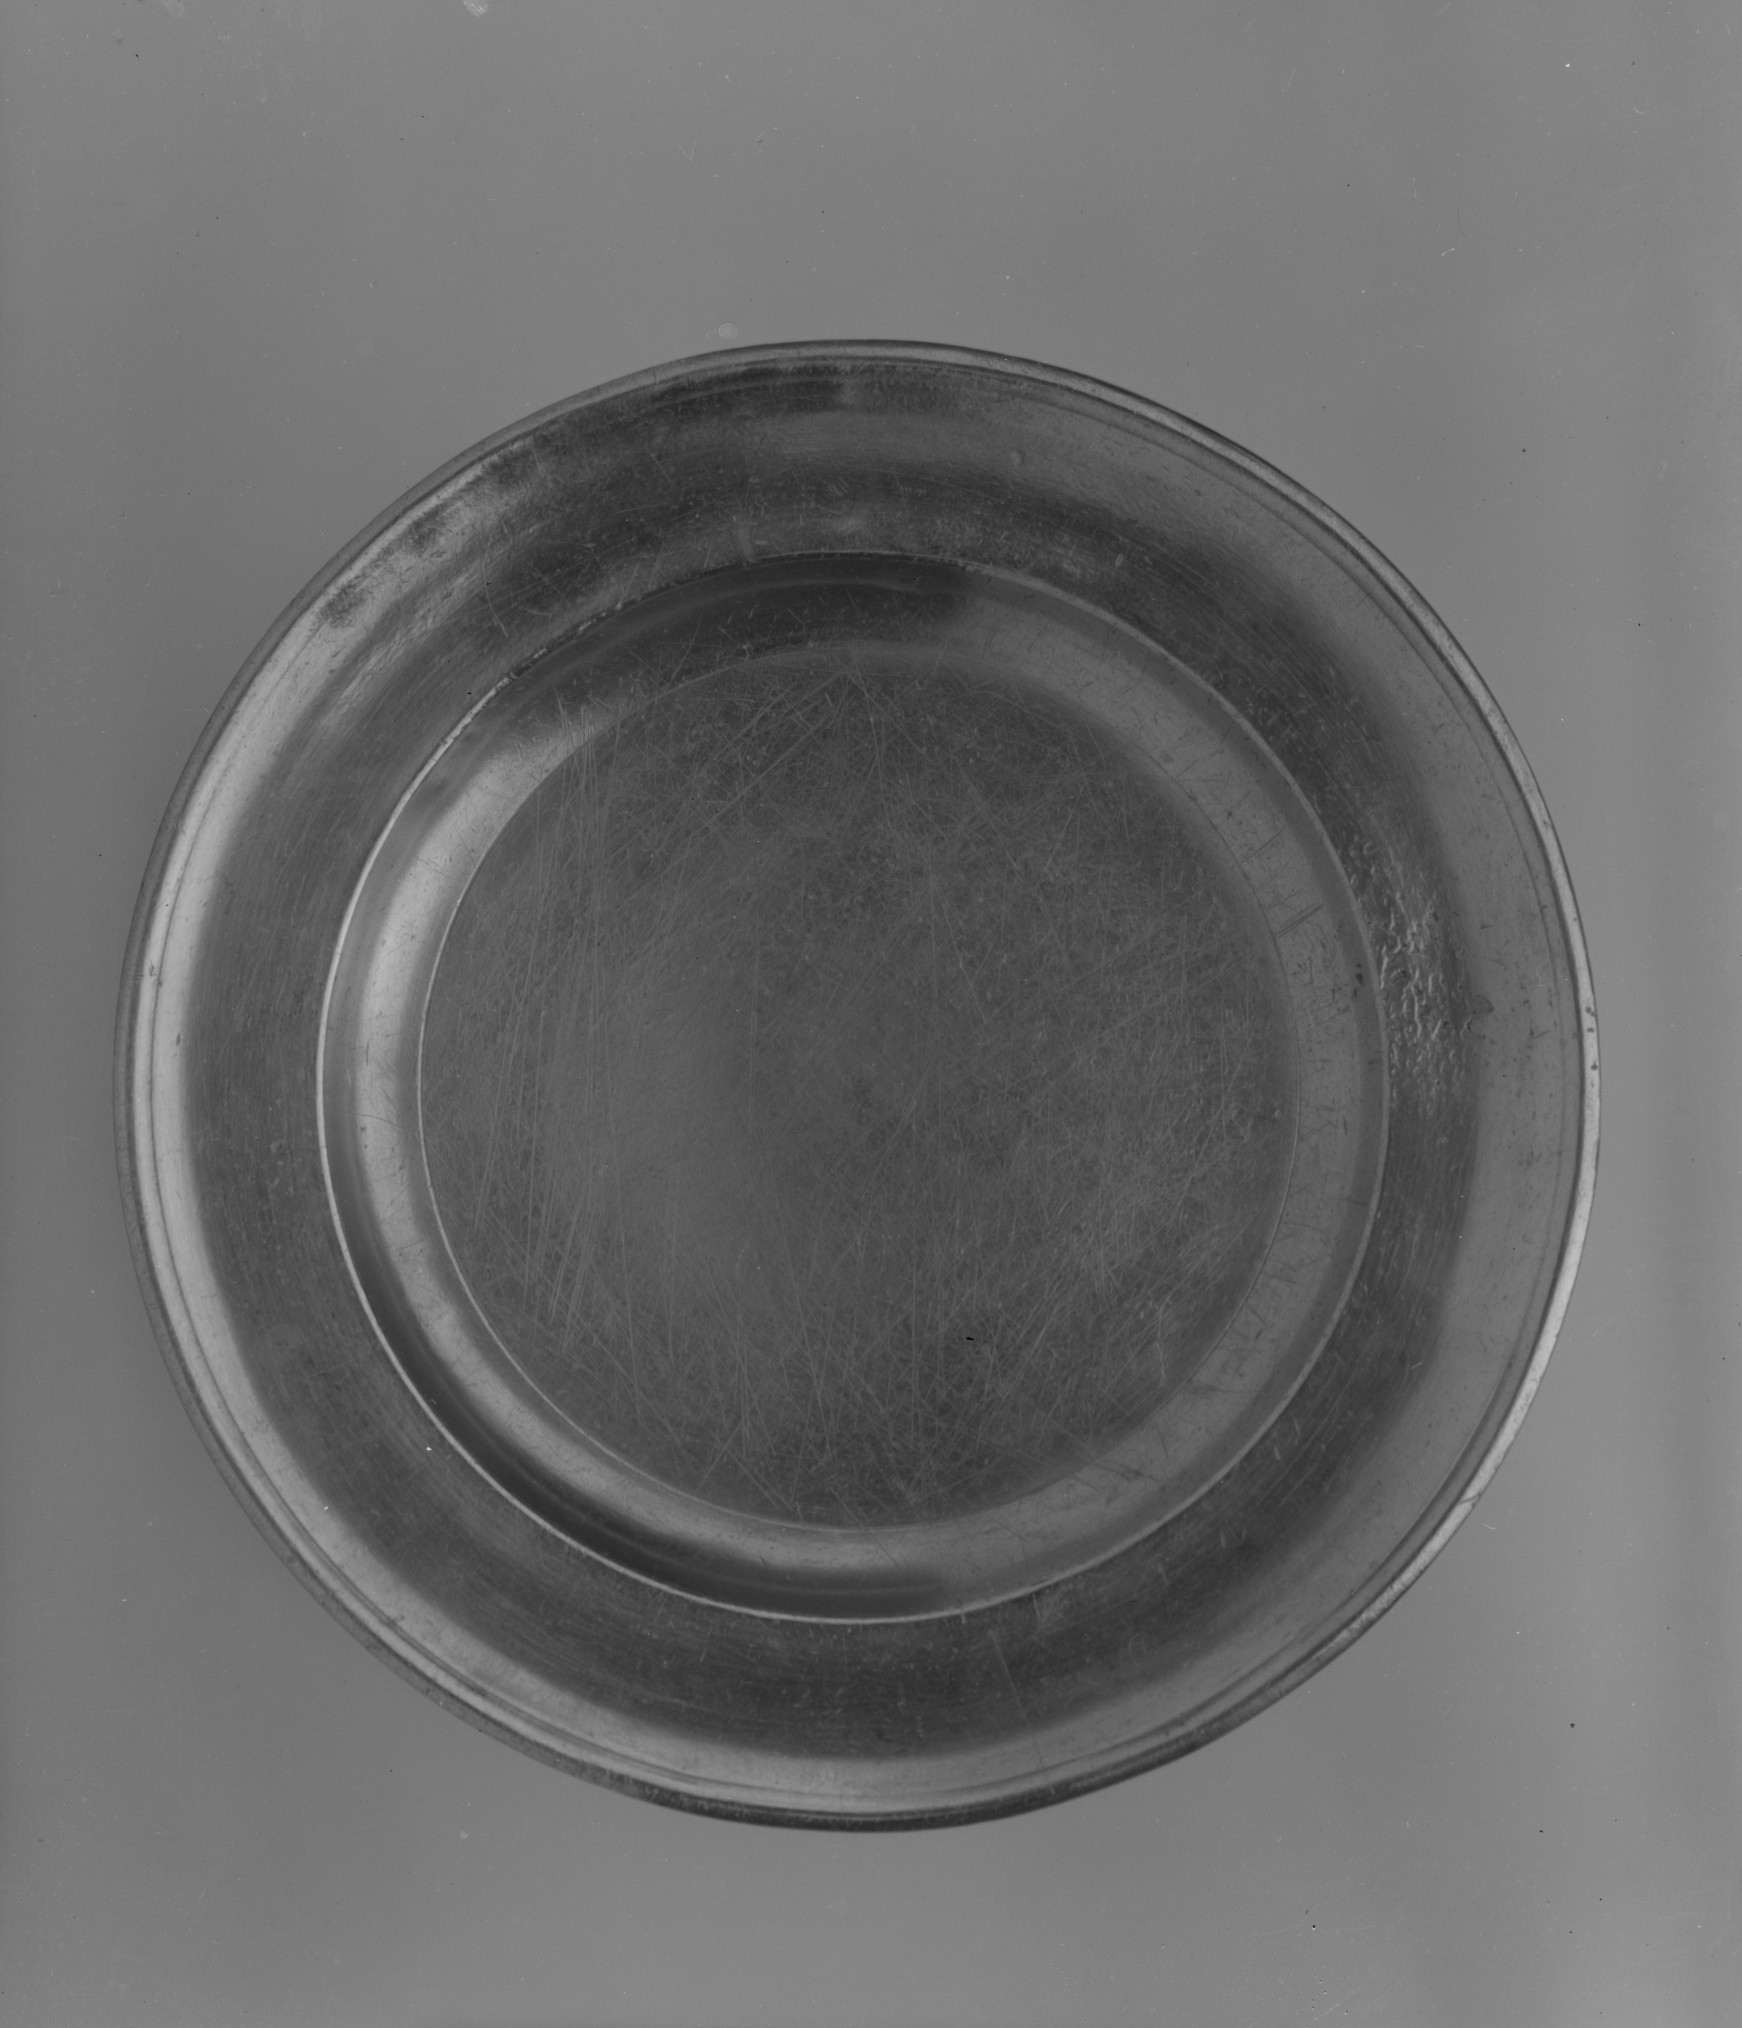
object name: plate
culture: american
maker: jehiel johnson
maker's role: maker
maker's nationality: american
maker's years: 1781-1833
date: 1815-1825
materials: pewter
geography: united states